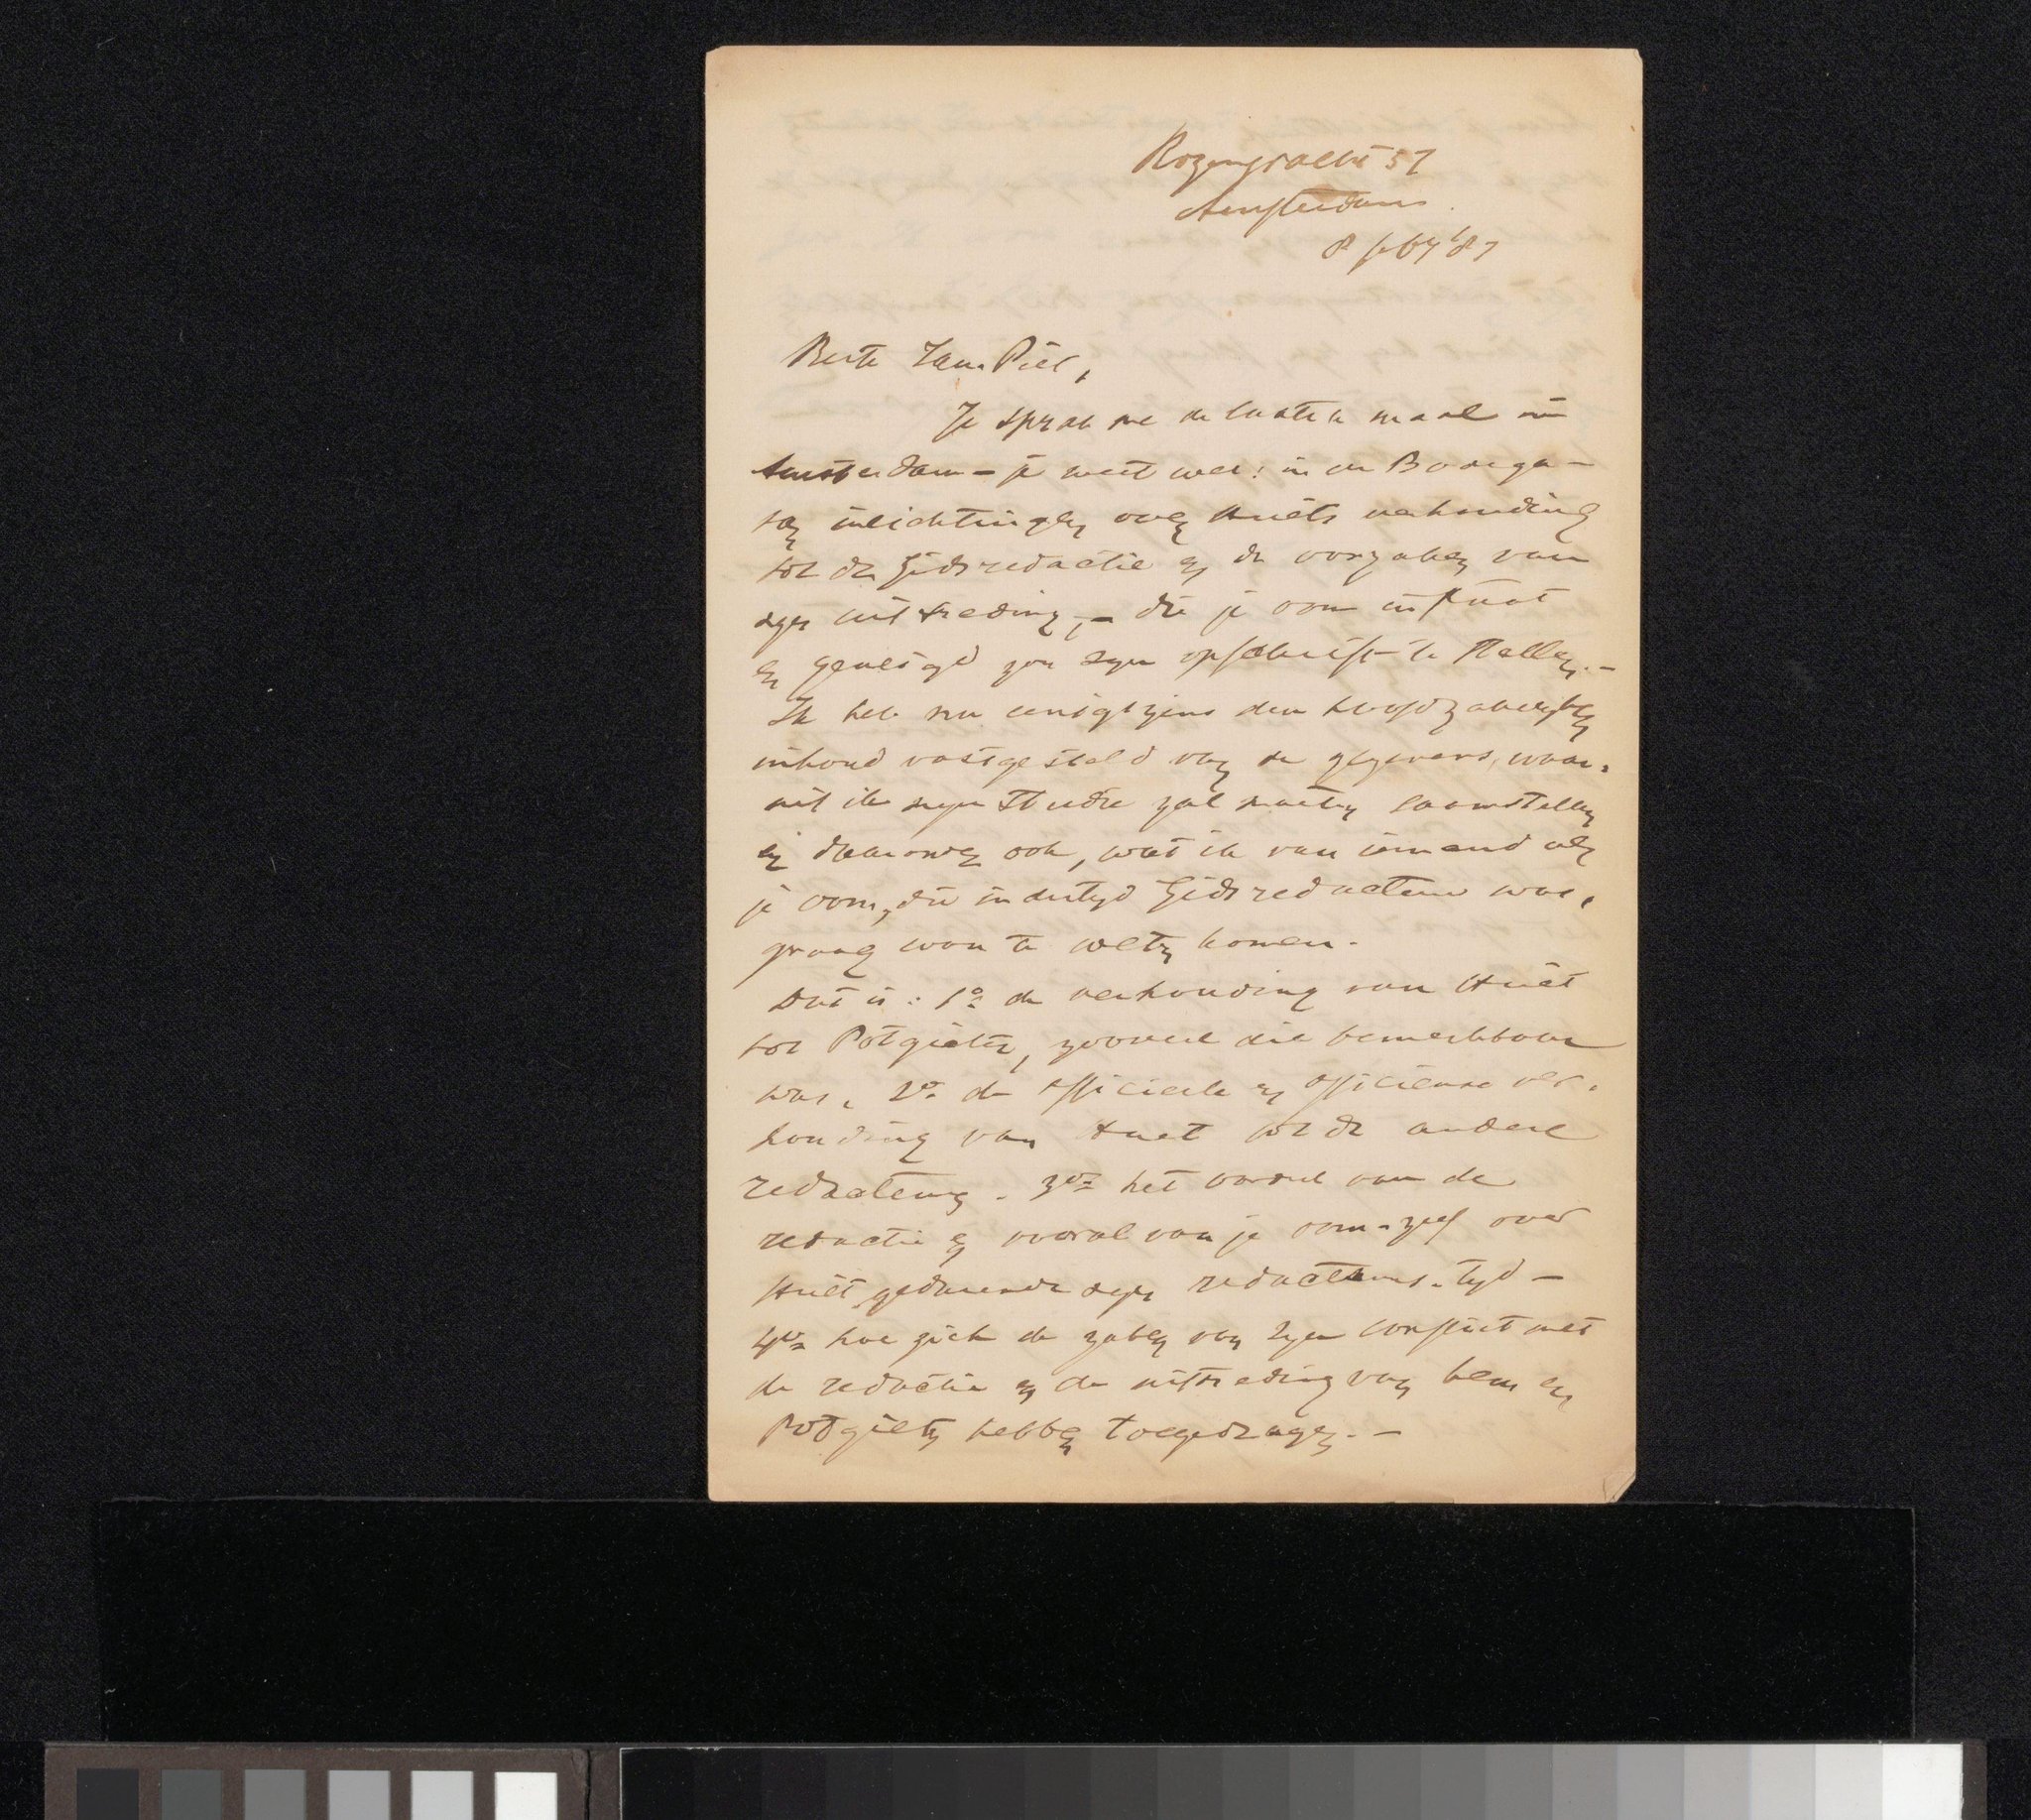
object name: letter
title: Brief aan Jan Veth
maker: albert verwey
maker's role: criticus, dichter, essayist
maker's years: 1865-1937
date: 1887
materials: ink, paper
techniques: pen, writing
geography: amsterdam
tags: painter, print maker, draughtsman, designer, jan veth, everhardus johannes potgieter, dordrecht, amsterdam, chap van deventer, the hague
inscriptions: collector's mark: ‘RPK’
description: Opgenomen in: Verwey, Albert, Margaretha H. Schenkeveld, Rein van der Wiel: Briefwisseling 1 juli 1885 tot 15 december 1888, Amsterdam: EM. Querido's Uitgeverij B.V., 1993, p. 279-280.